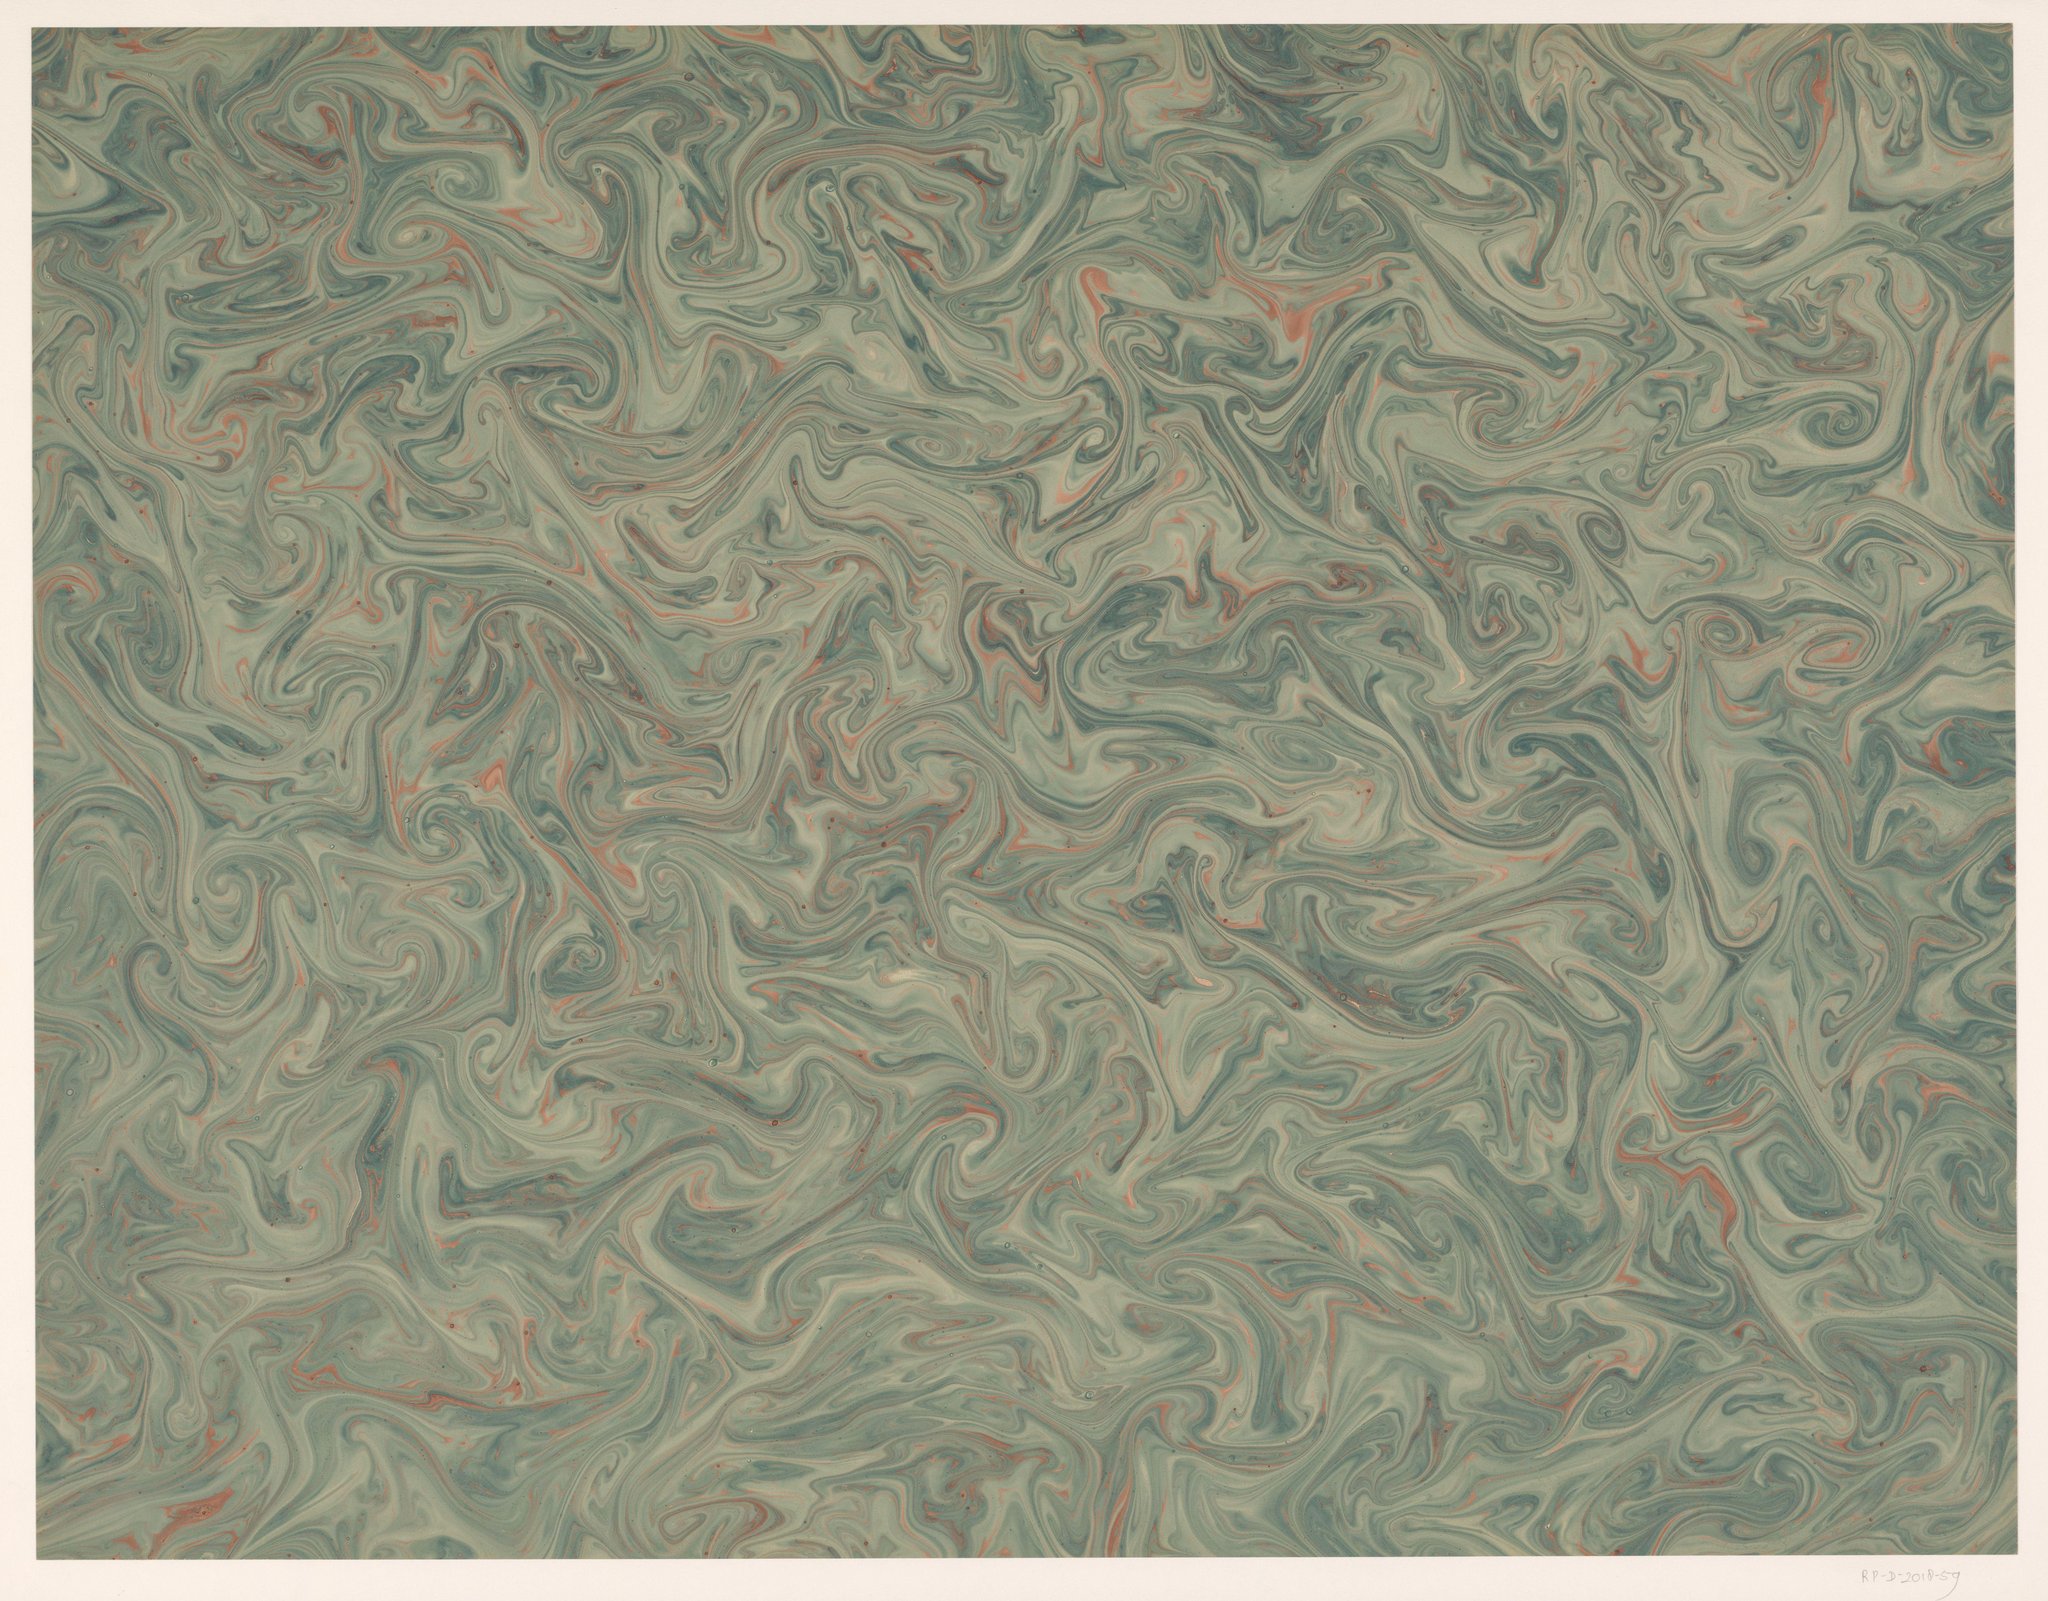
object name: marbled paper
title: Fantasiemarmer in twee tinten groen en oranje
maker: Anonymous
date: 1900-2000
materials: paint, paper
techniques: marbled paper